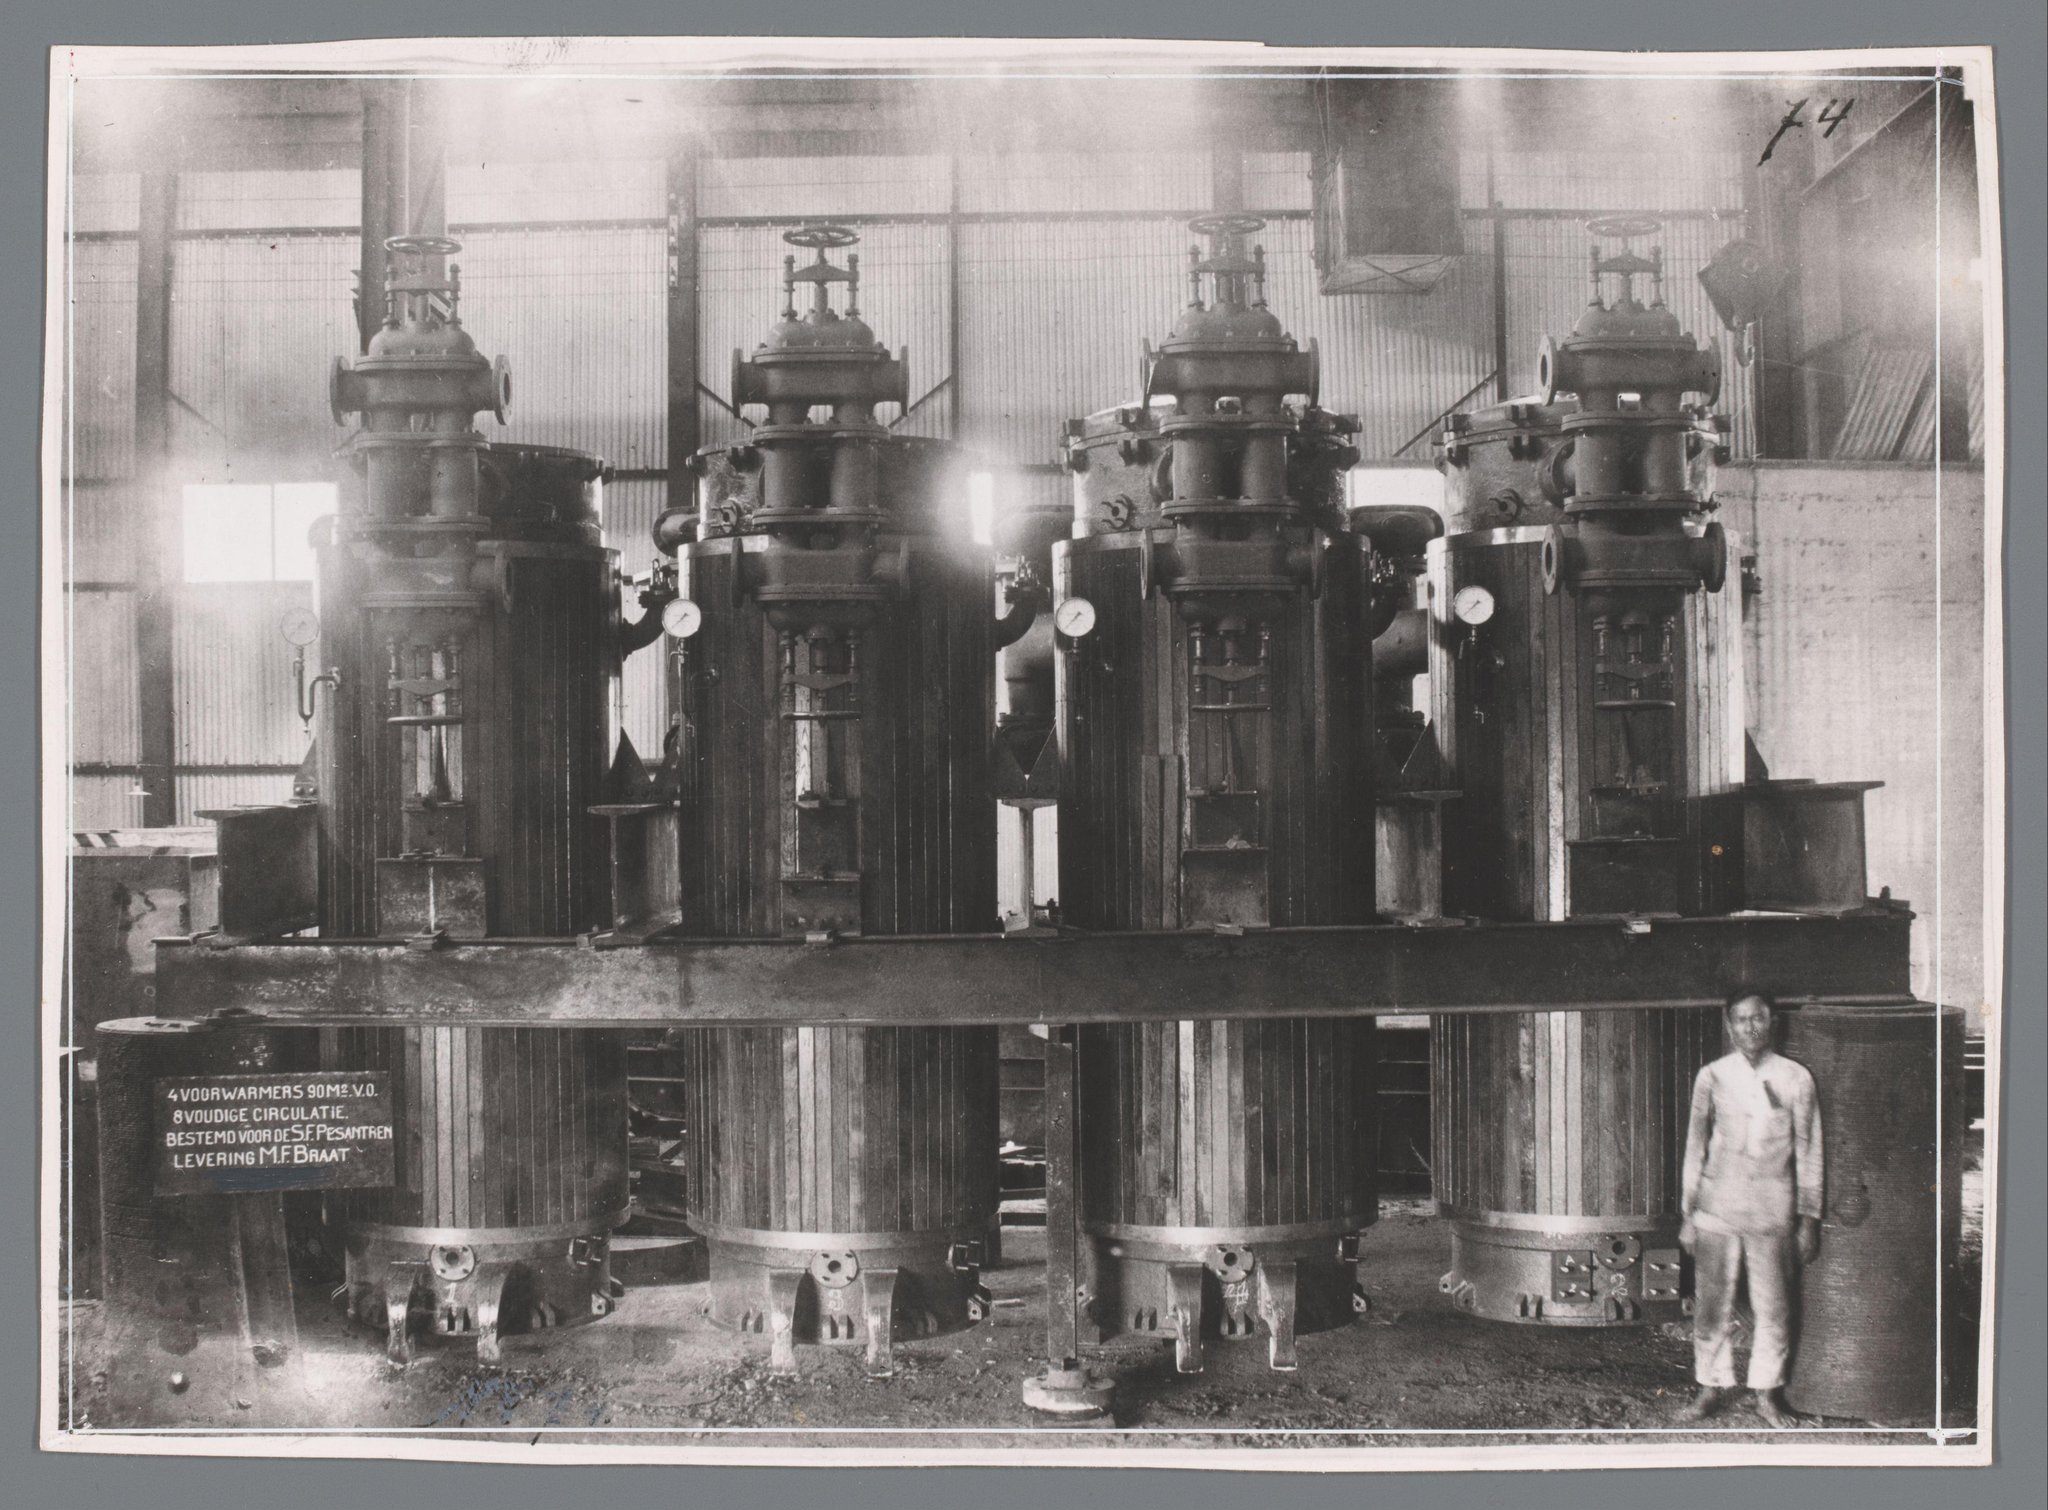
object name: photograph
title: Voorverwarmers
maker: Anonymous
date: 1917-1938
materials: photographic support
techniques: gelatin silver print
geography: surabaya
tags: colonial system, factory-interior, machine shop, machines; parts of machines; tools and appliances, (non-fruit) products of plants or trees: sugarcane, java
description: Vier voorverwarmers bestemd voor de Suikerfabriek Pesantren bij Kediri. Onderdeel van de multomap met foto's van machines van de N.V. Machinefabriek Braat te Soerabaja bestemd voor de Nederlandse suikerindustrie op Java, uit de periode 1917-1938.